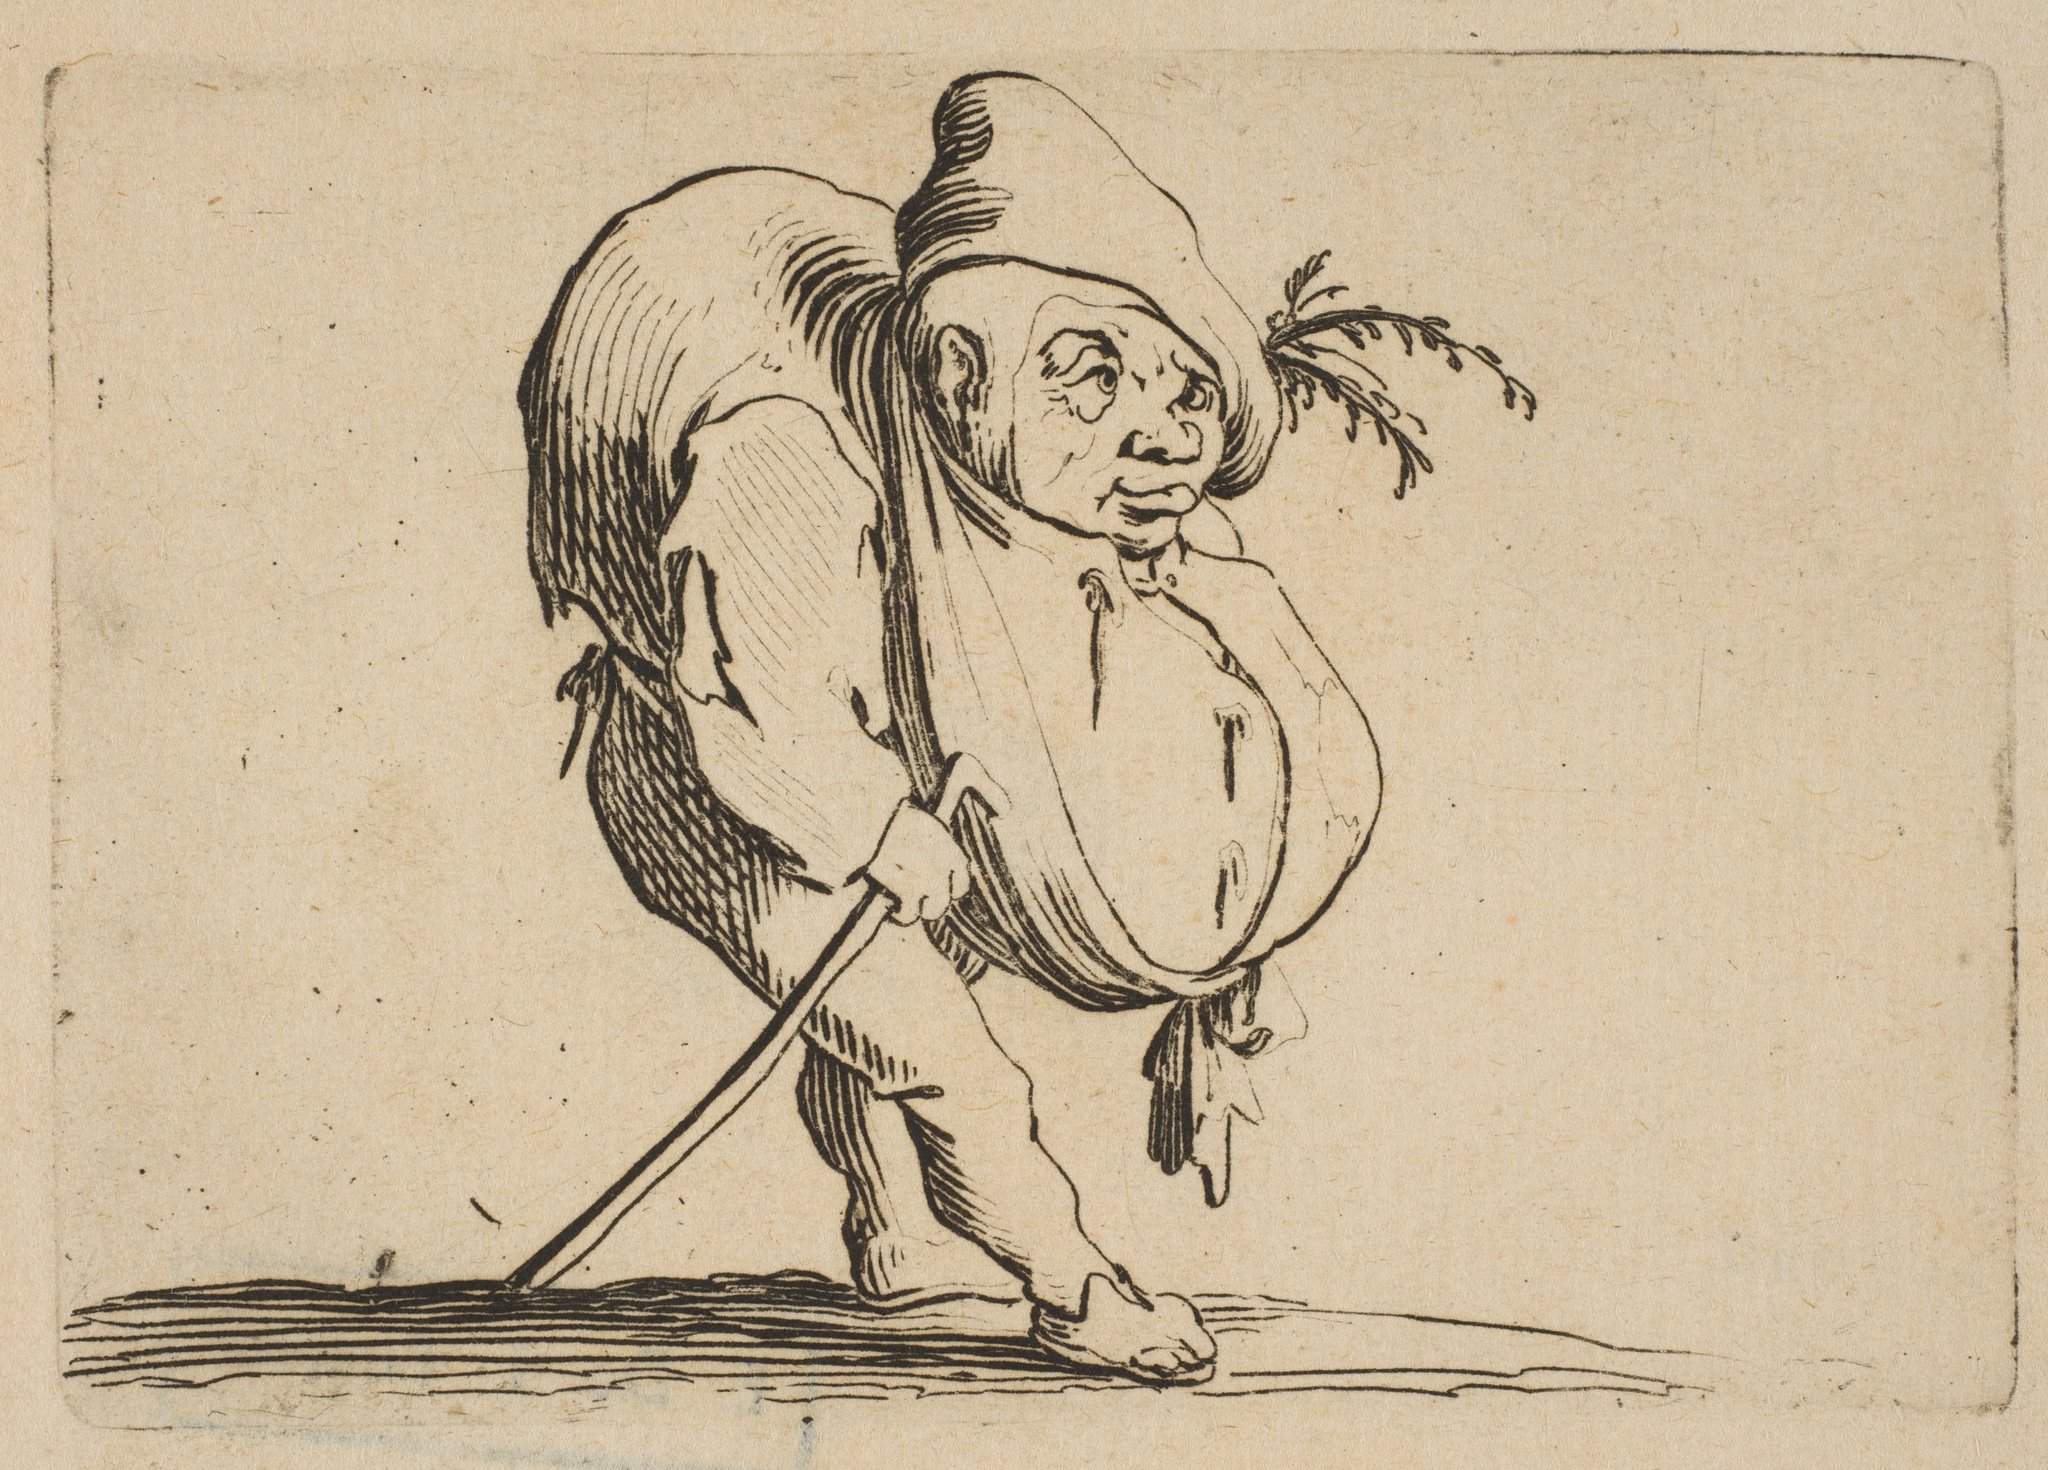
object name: print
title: Le Bossu a La Canne (The Hunchback with a Cane), from "Varie Figure Gobbi, suite appelée aussi Les Bossus, Les Pygmées, Les Nains Grotesques" (Various Hunchbacked Figures, The Hunchbacks, The Pygmes, The Grotesque Dwarfs)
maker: jacques callot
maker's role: artist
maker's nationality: french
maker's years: 1592-1635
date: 1616-1622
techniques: engraving, etching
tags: men